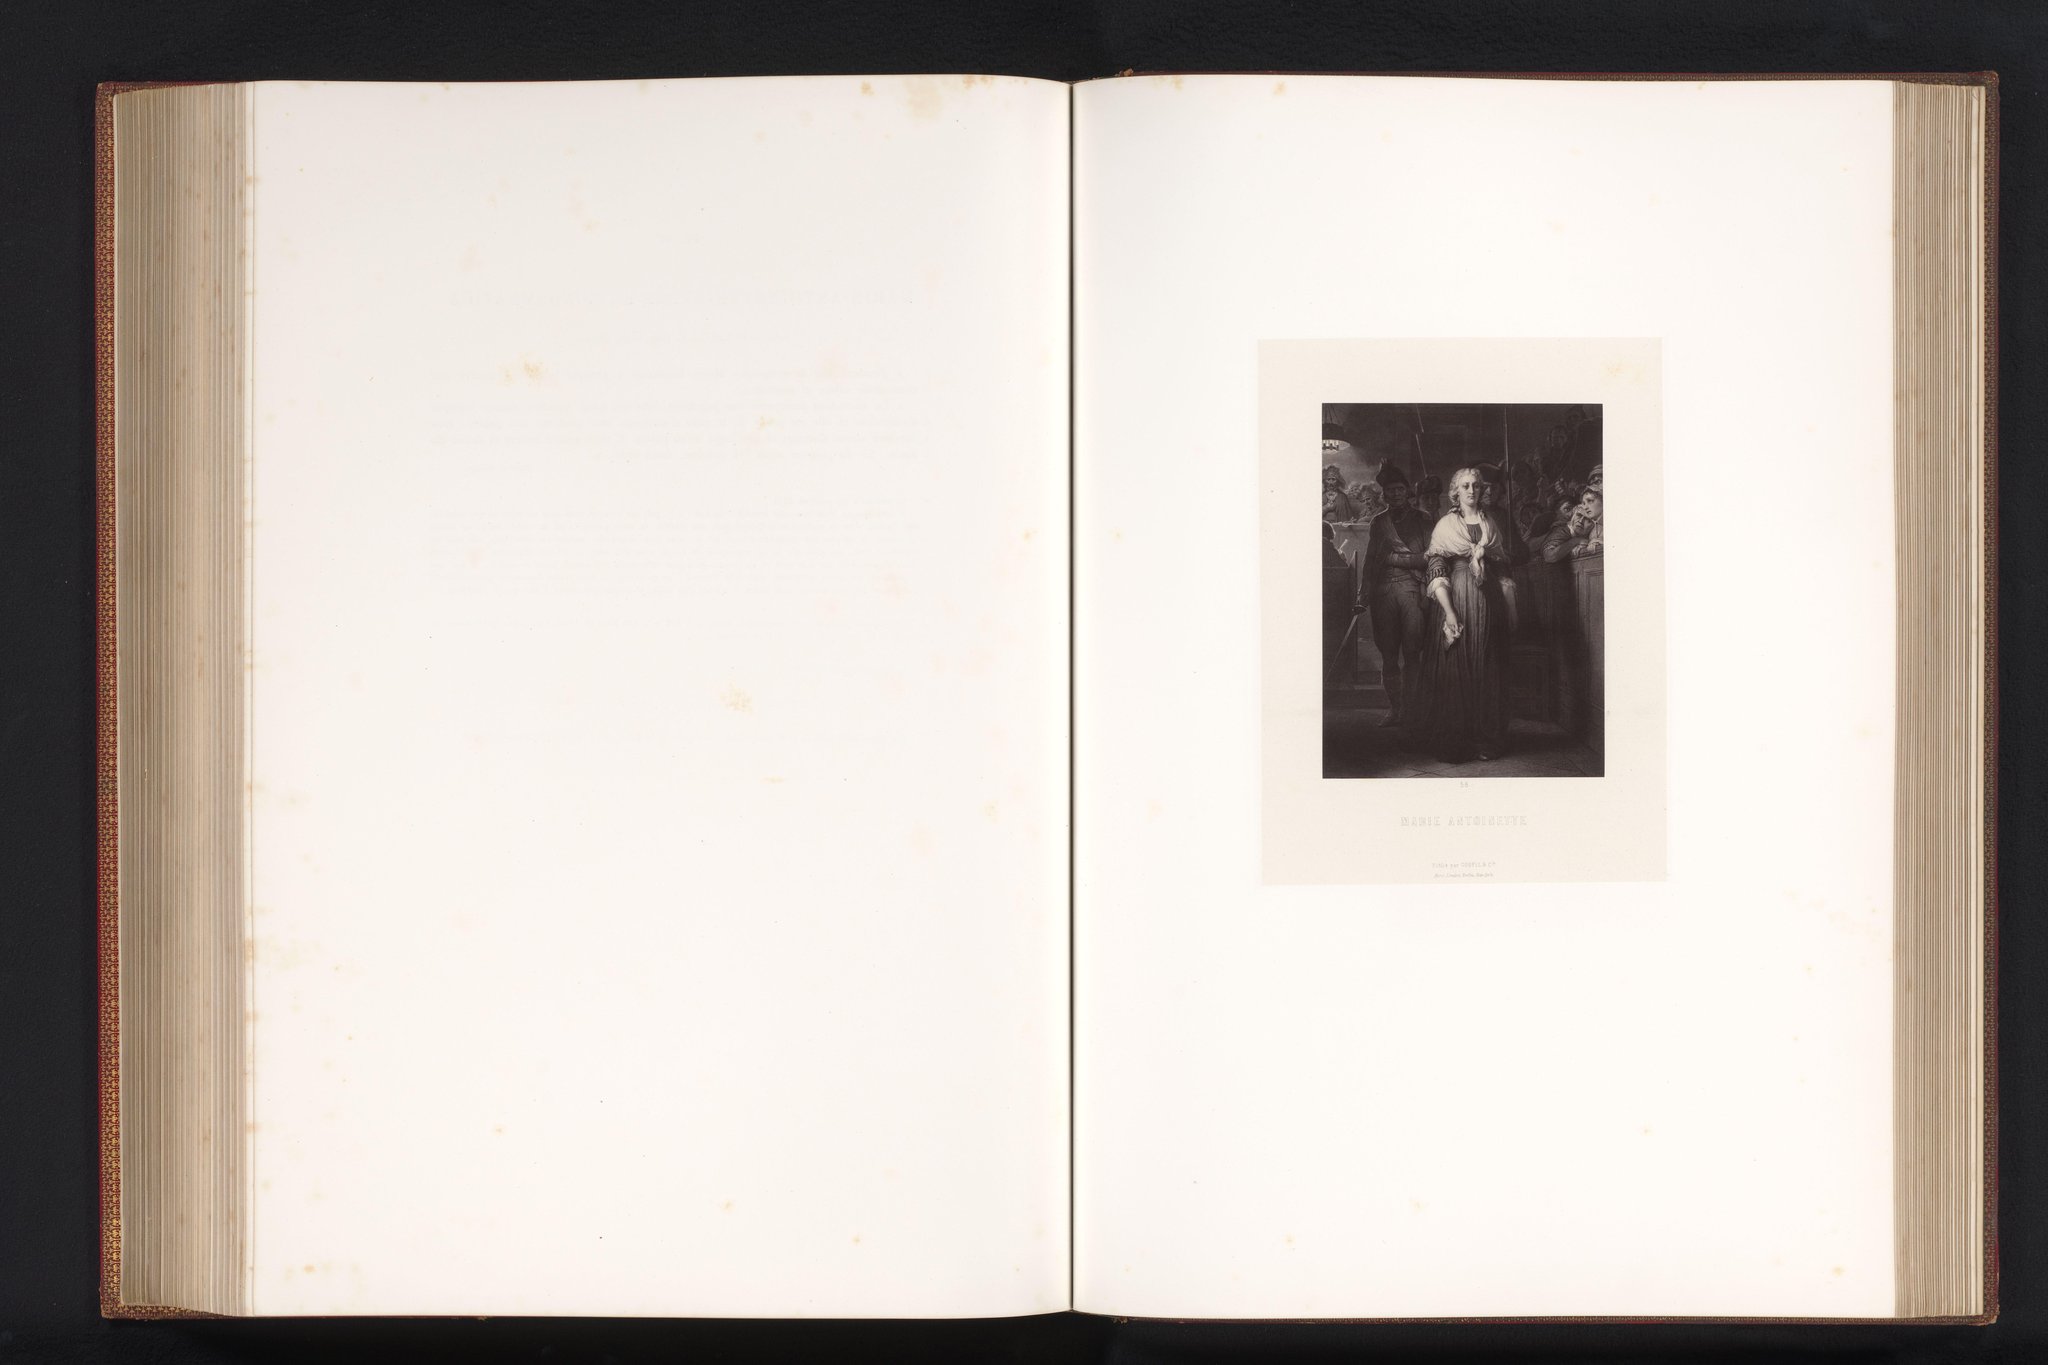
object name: page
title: Fotoreproductie van een prent naar een schilderij van de veroordeling van Marie Antoinette door Paul Delaroche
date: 1853-1858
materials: paper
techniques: albumen print, engraving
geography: paris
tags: marie antoinette, queen, empress, etc. (wife of a ruler), court session (court of justice)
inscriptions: check stamp: ‘Goupil & Cie’